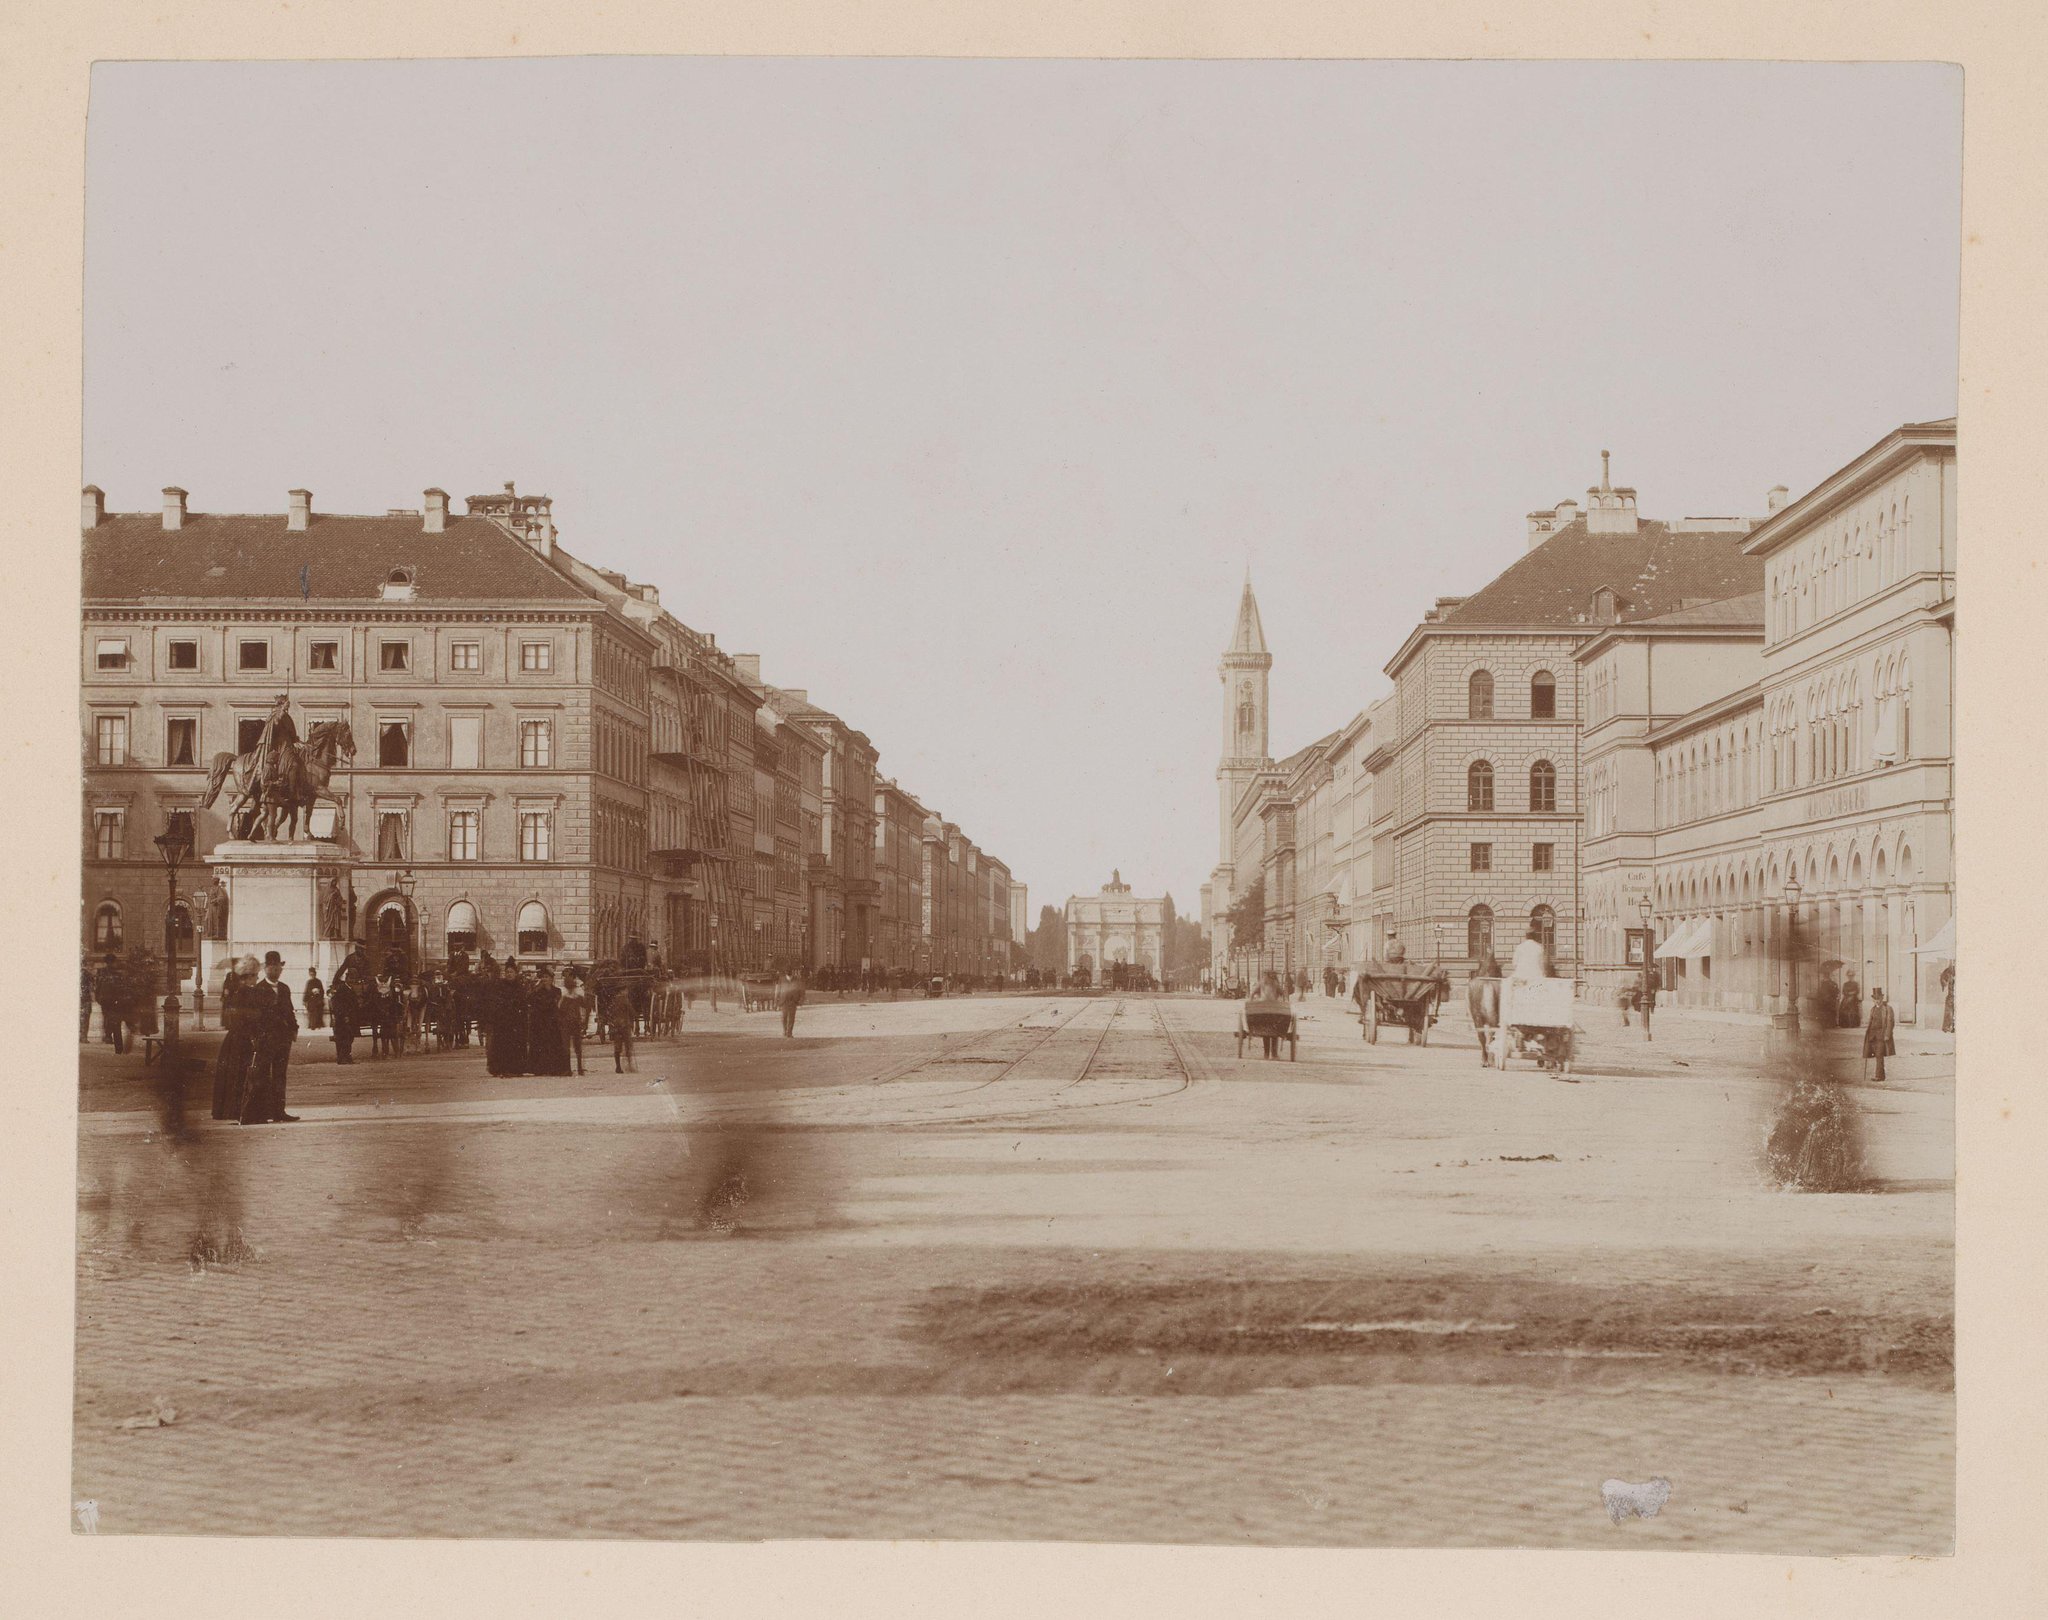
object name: photograph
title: Aanzicht op een plein, München, Duitsland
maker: Anonymous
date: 1880-1910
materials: cardboard, photographic support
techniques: collodion silver print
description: Aanzicht op een plein [Marienplatz?], met een stadspoort [?] op het eind van een lange straat met tramrails. Links een ruiterstandbeeld en een groep poserende mensen. Verder enkele paardenkoetsen.